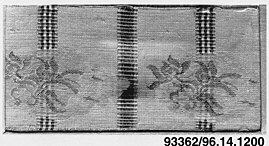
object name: piece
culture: japanese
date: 1701-1900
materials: silk